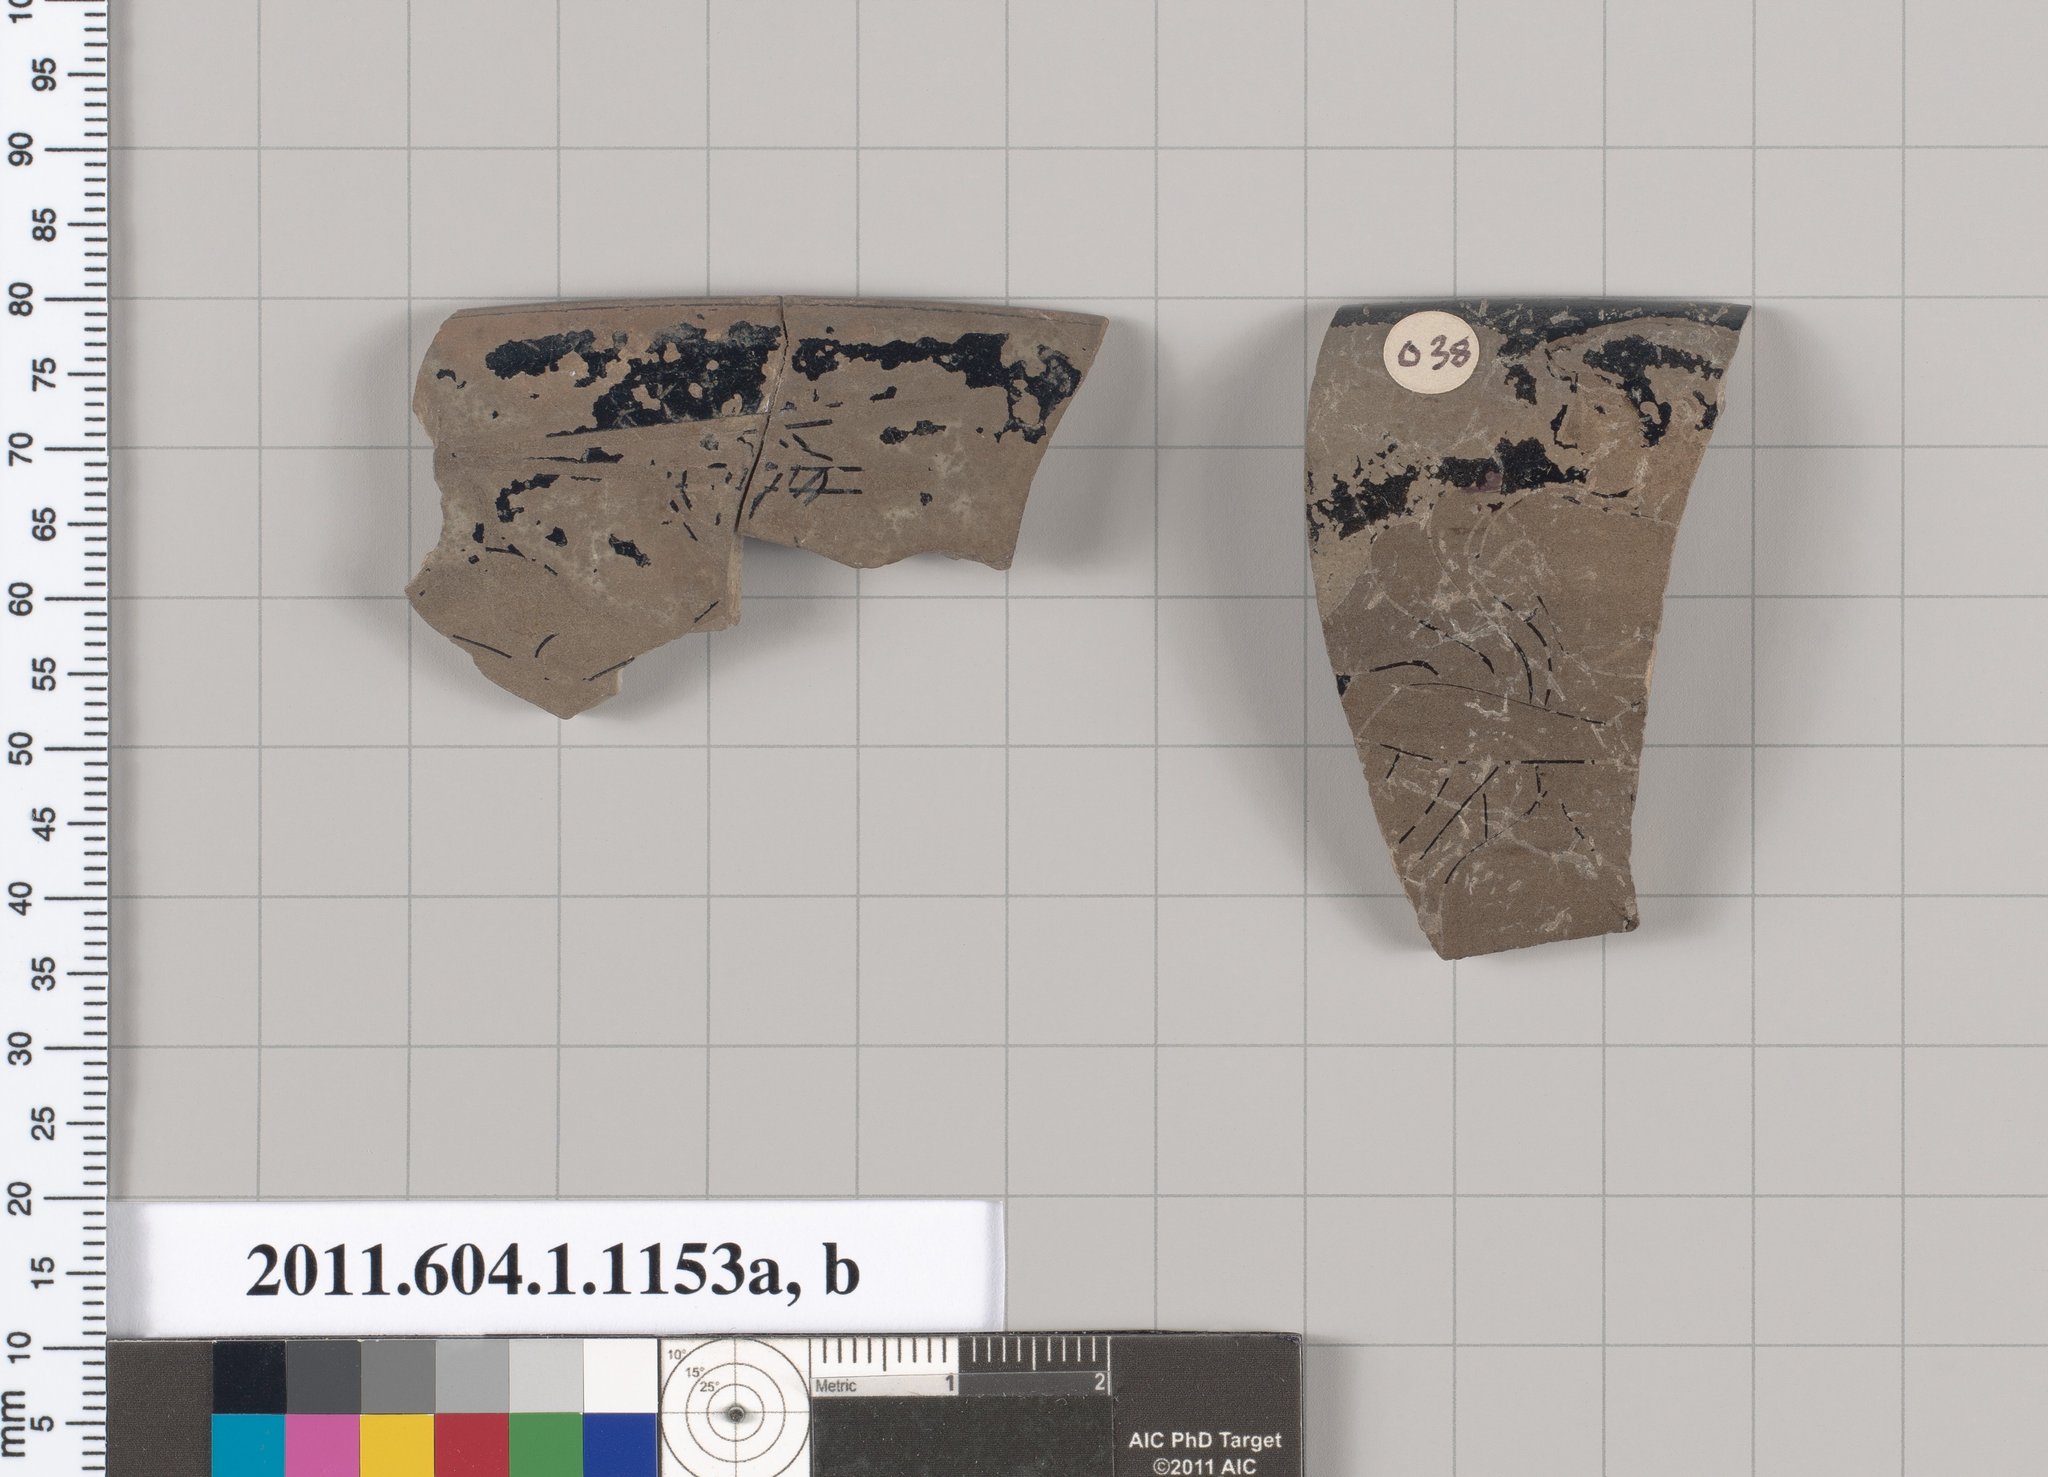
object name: kylix fragment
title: Terracotta rim fragments of a kylix (drinking cup)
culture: greek, attic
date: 500-476 BCE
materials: terracotta